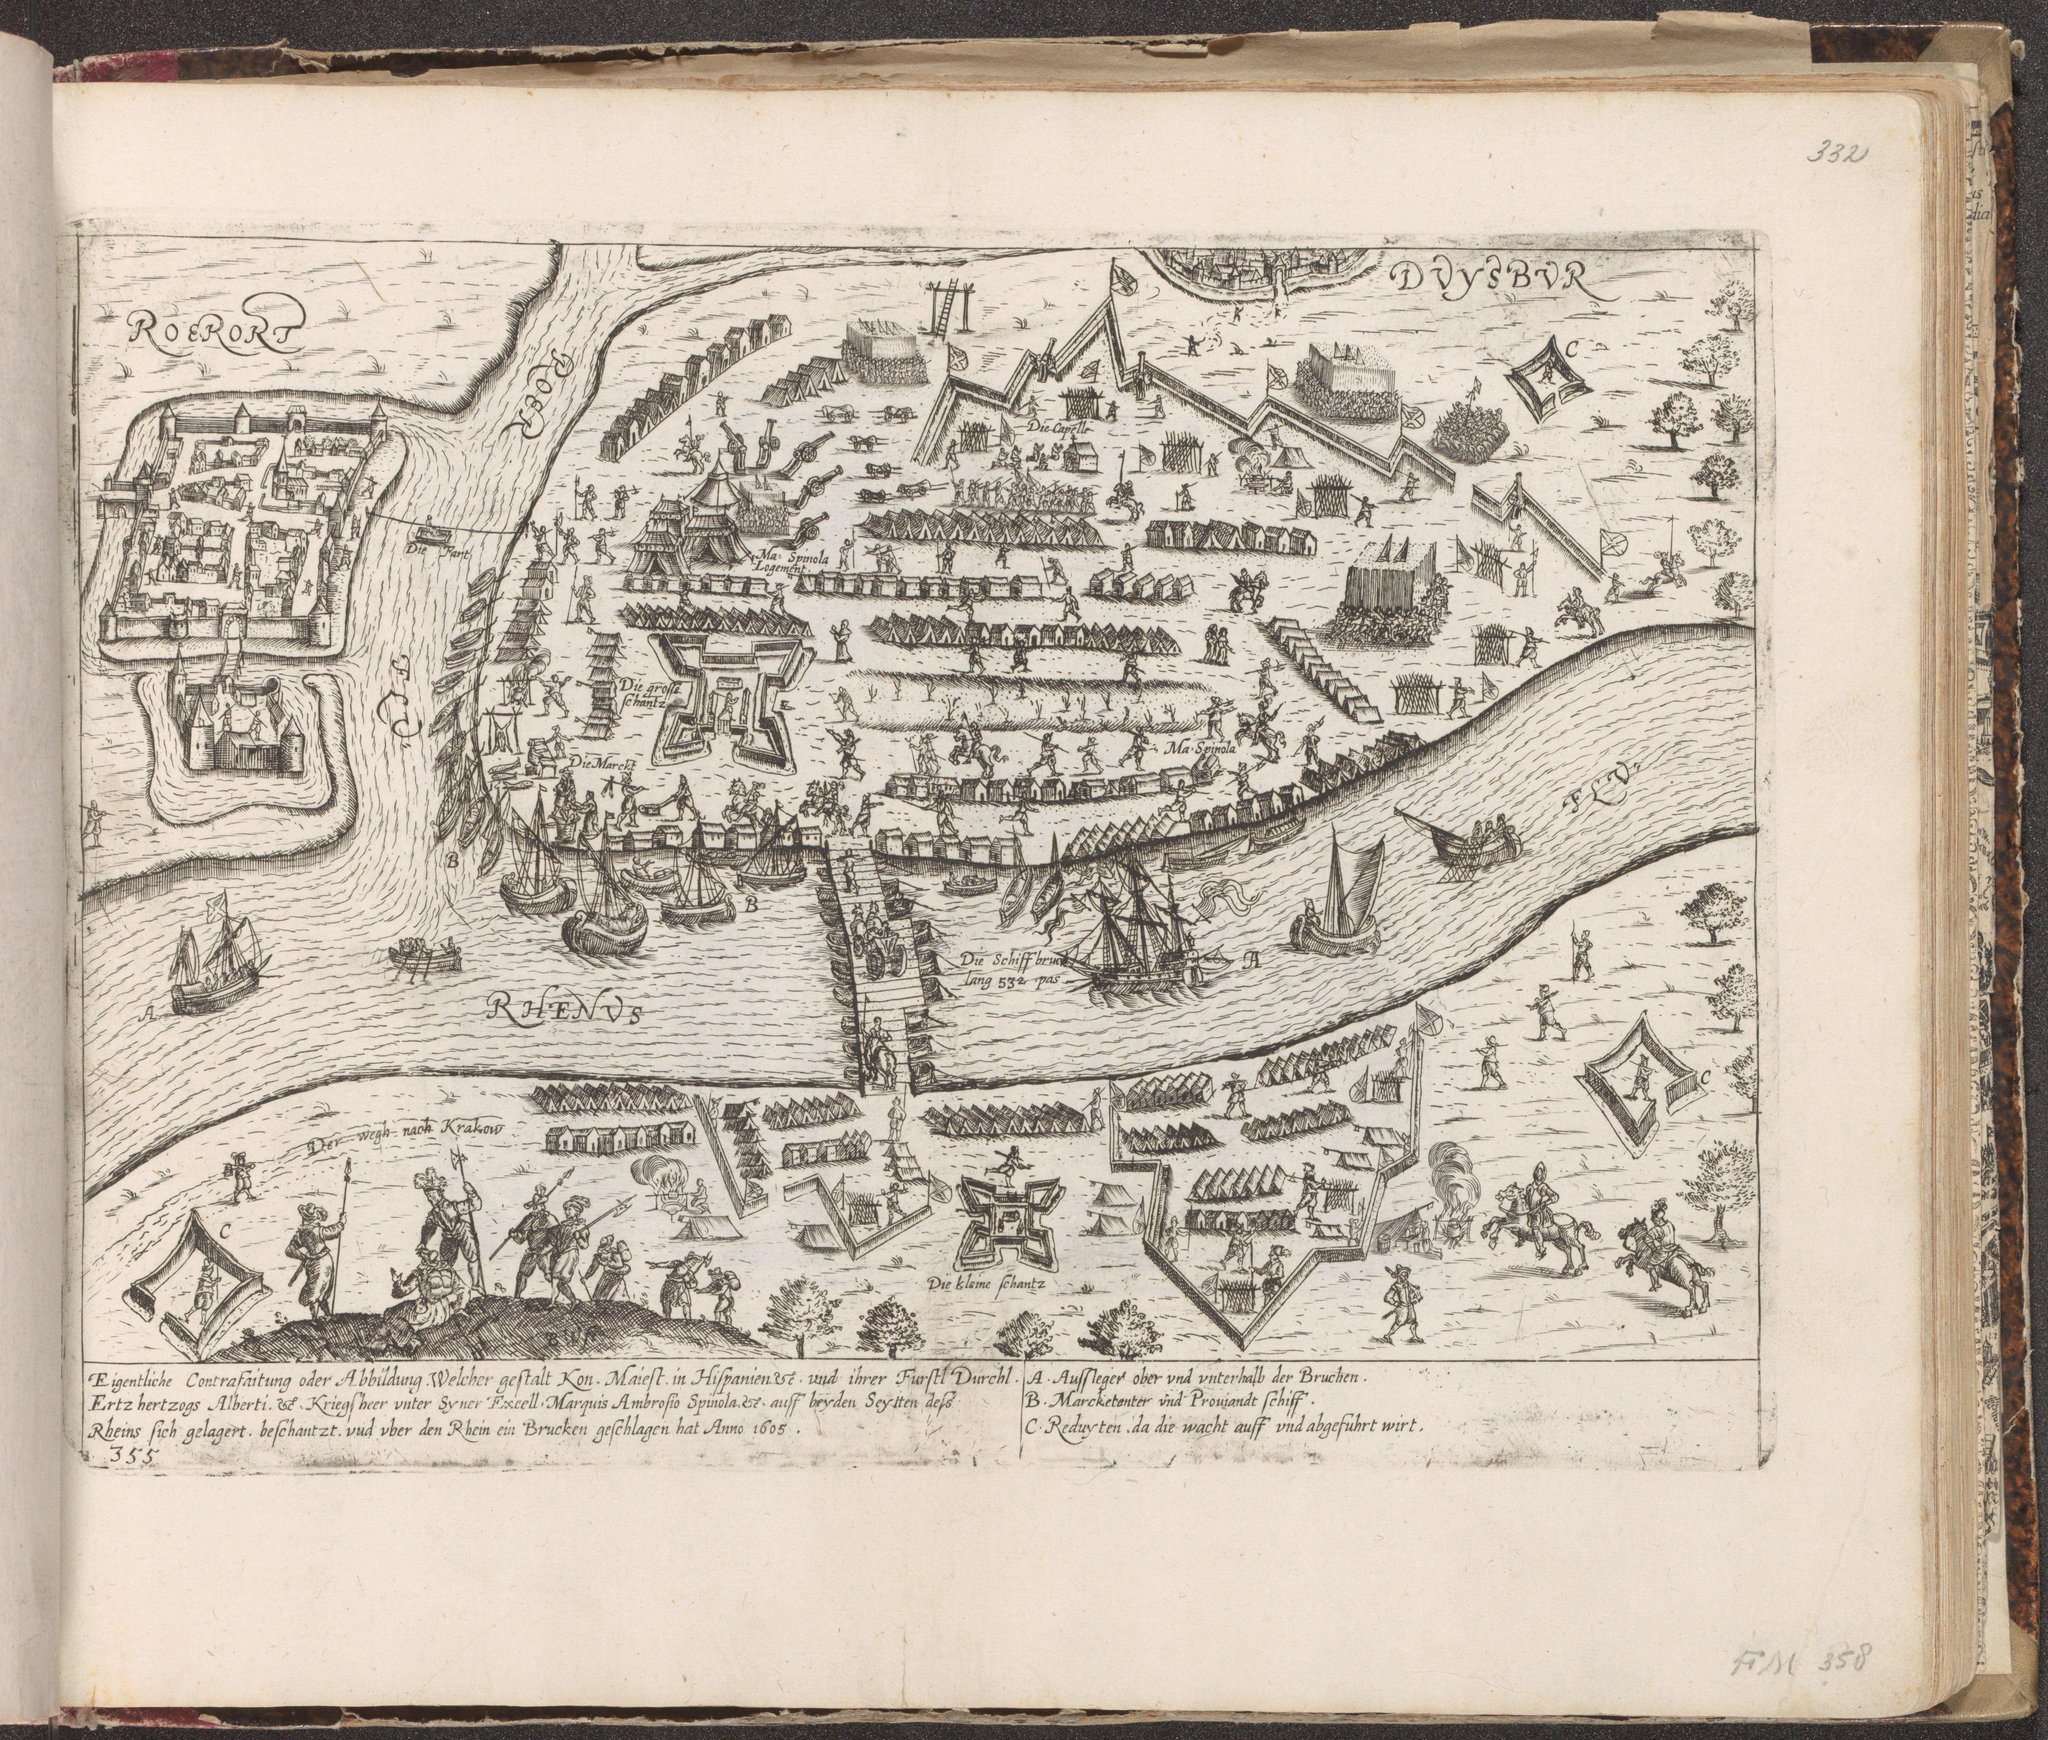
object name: print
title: Legerkamp van Spinola voor Ruhrort, 1605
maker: frans hogenberg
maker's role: print maker, publisher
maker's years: 1538-1590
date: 1605-1607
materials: paper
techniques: etching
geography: cologne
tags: (military) camp with tents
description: Legerkamp van Spinola tussen Ruhrort en Duisburg, 1605. In het onderschrift de titel en legenda A-C, in het Duits. Linksonder genummerd: 355. De prent maakt deel uit van een album.